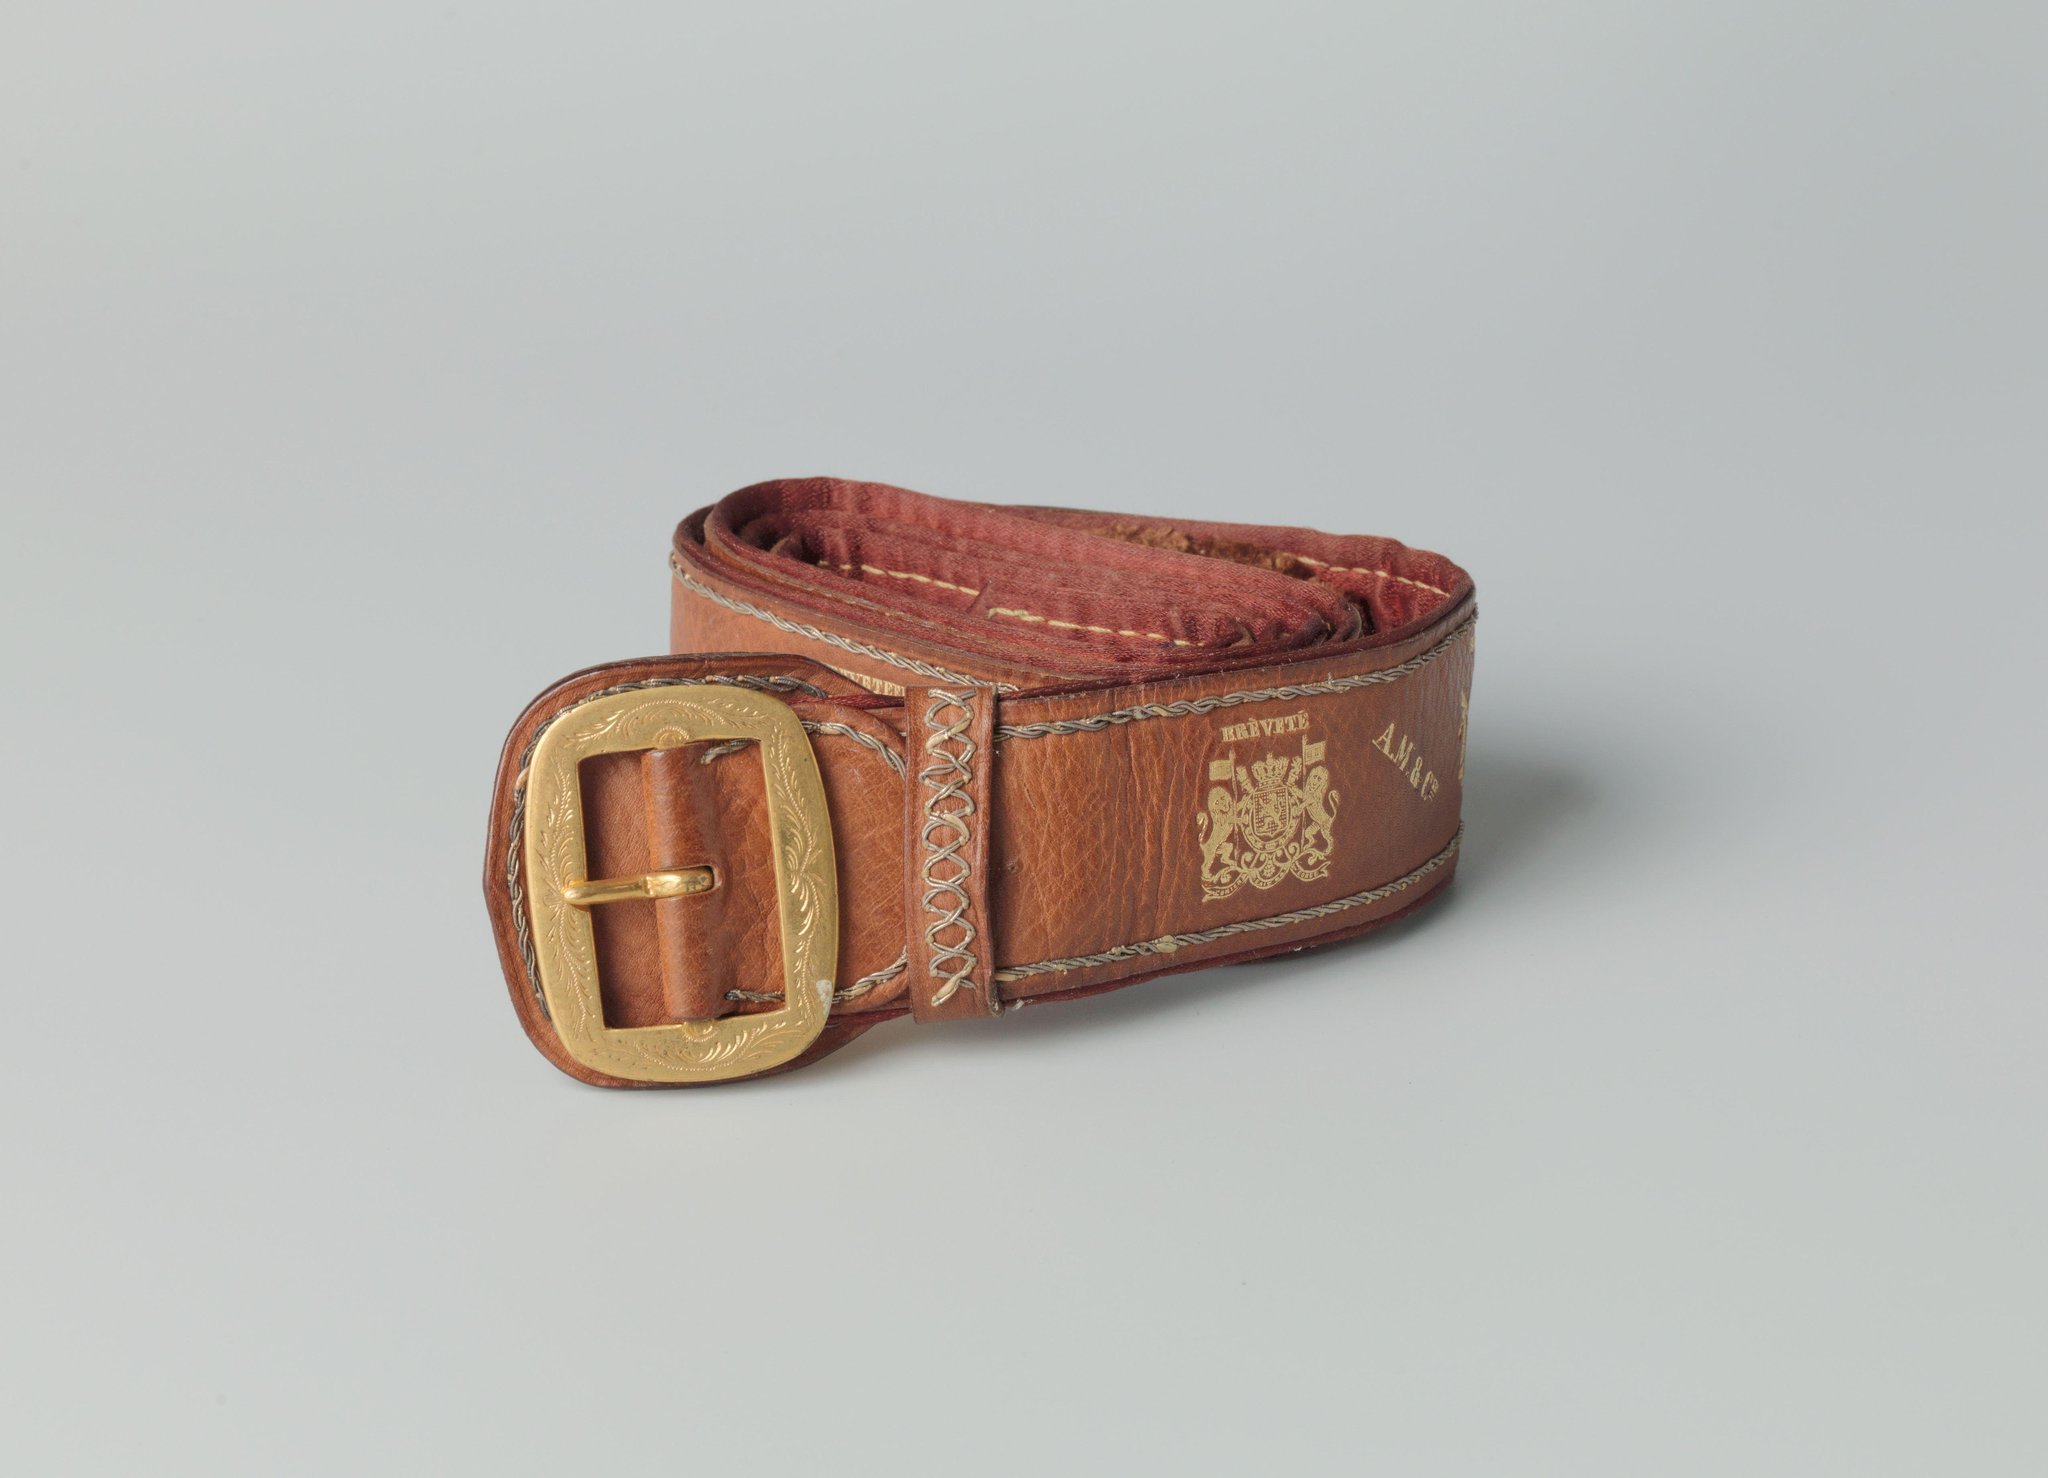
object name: riem kledingaccessoire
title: Electro aromatic belt patented against sea sickness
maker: alphonse l.e. mosselman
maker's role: uitvinder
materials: copper, leather, silk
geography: brussels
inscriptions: inscription: ‘DEPOSE A.M. & CIE’, inscription: ‘CEINTURE AROMALE ELECTRIQUE CONTRE LE MAL DE MER’, inscription: ‘GERREVETEERT JE MAINTIENDRAI’, inscription: ‘BRÉVETÉ L'UNION ...FORCE’, inscription: ‘PATENT DIEU ET MON DROIT HONY SOIT QUI MAL Y PENSE’, inscription: ‘BRÉVETÉ’, inscription: ‘ELECTRO AROMATIC BELT PATENTED AGAINST SEA SICKNESS’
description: Bruine leren riem met gouden opdruk, binnenkant van rode zijde. Indien de riem wordt gedragen zit er in de zij een harde uitstulpsel die waarschijnlijk zeeziekte tegengaat. Aan de buitenkant daarvan een koperen rechthoekig plaatje waarnaast 14 verticale en 2 horizontale pinnen om deze te bevestigen. Tevens vier emblemen in goud opgedrukt. Riem is opgerold in zwart ovalen foedraal met gouden opdruk. Zijkant kapot.